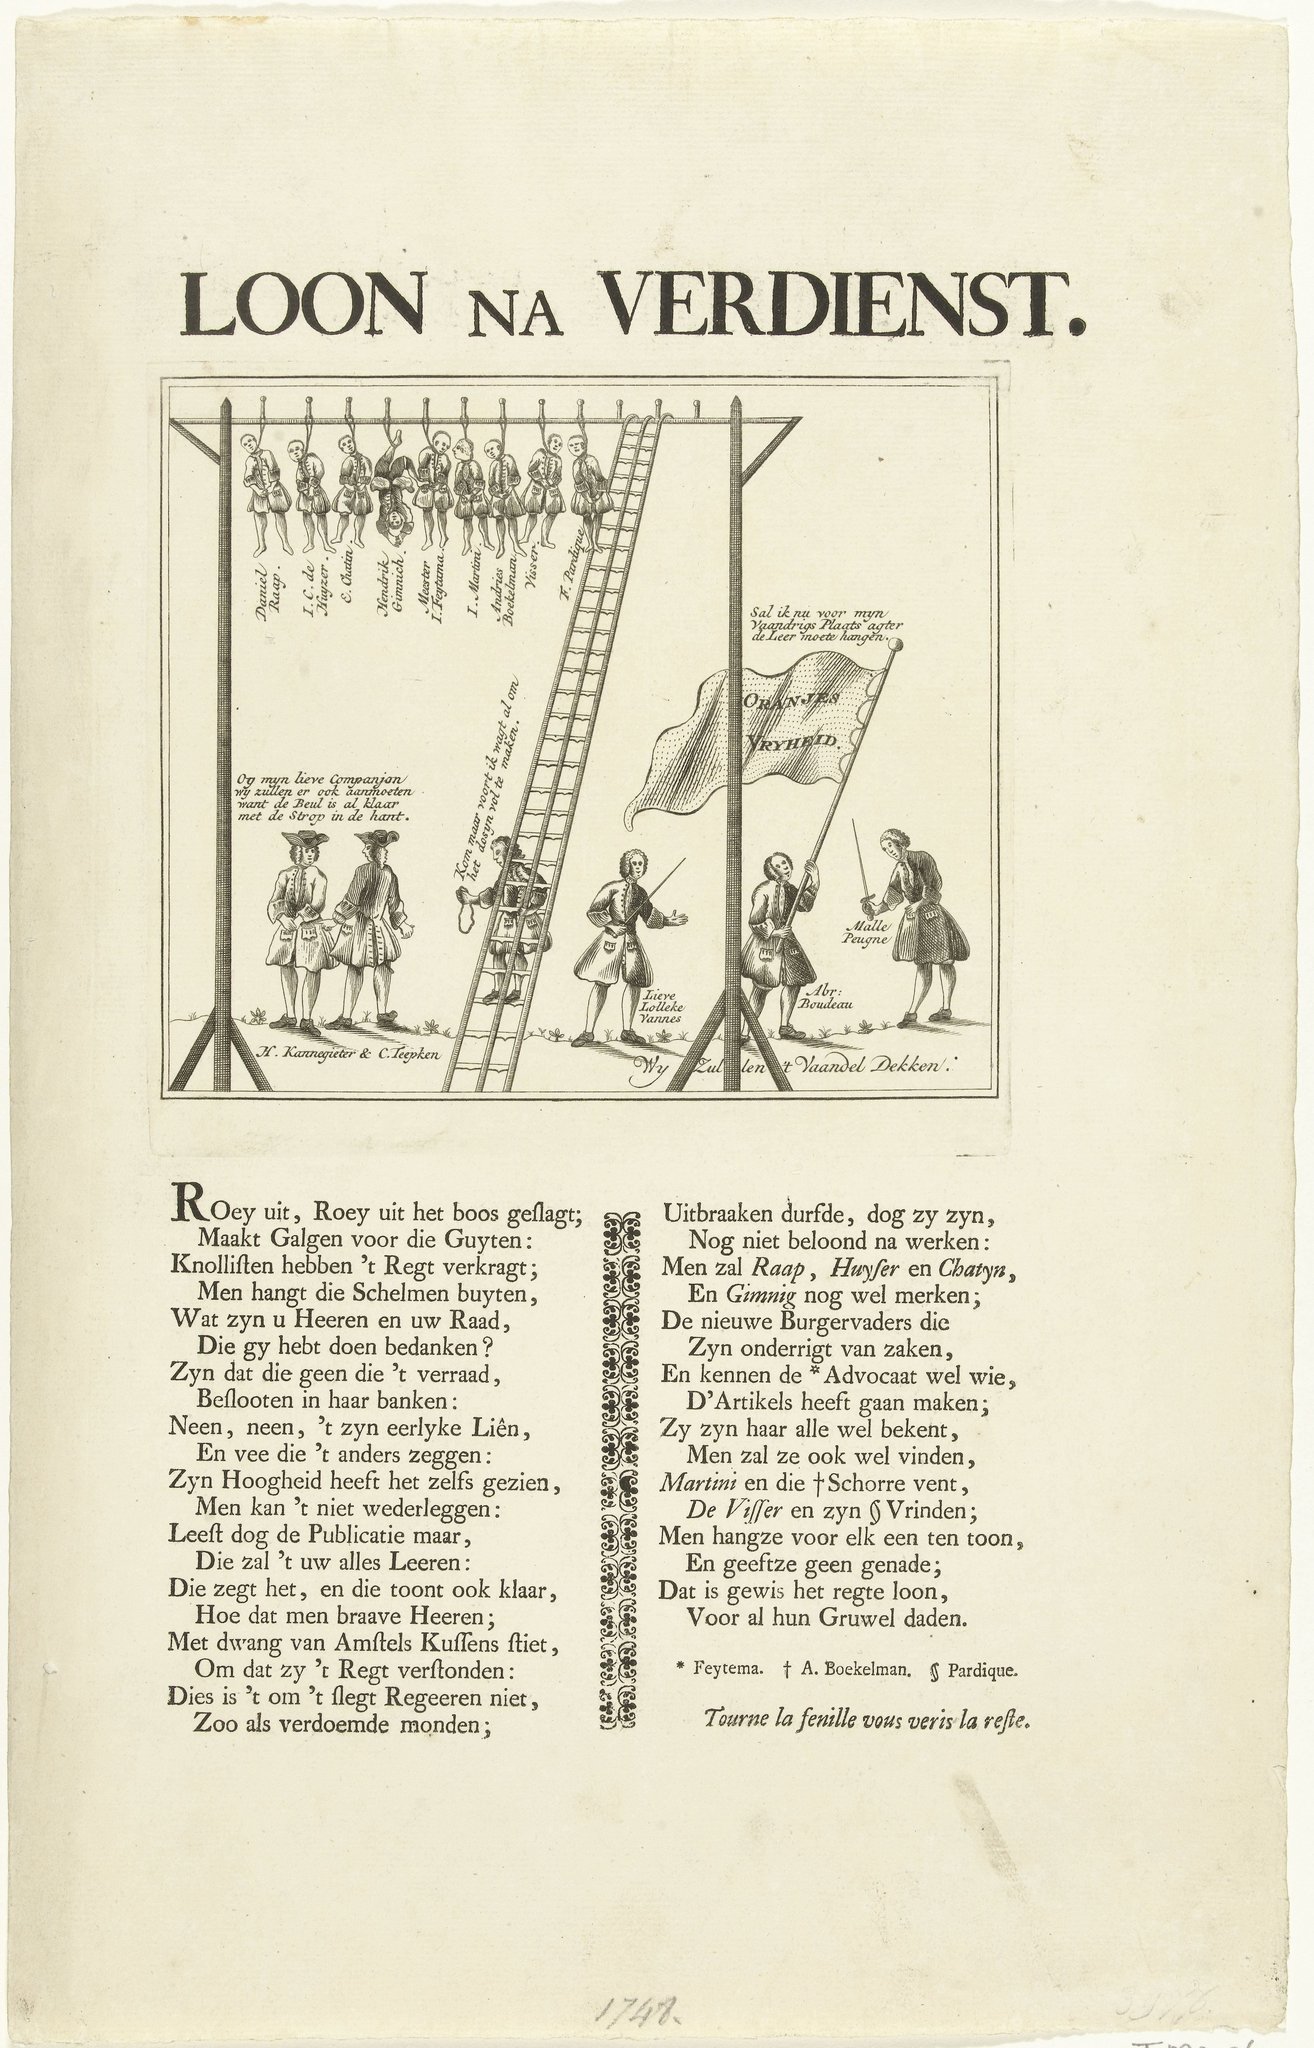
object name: cartoon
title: Loon na Verdienst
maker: Anonymous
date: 1748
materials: paper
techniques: engraving, etching, letterpress printing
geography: northern netherlands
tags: amsterdam, violent death by hanging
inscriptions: collector's mark: Lugt 2228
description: Spotprent op de Doelisten, 1748. Aan een galg hangen de lichamen van Daniël Raap en 8 anderen, de beul op een ladder dringt twee anderen haast te maken die ook gehangen moeten worden. Rechts twee personen met getrokken zwaarden en een derde met het vaandel: Oranjes Vryheid. Alle afgebeelde personen worden met naam aangeduid. Op het blad onder de plaat een vers in twee kolommen.